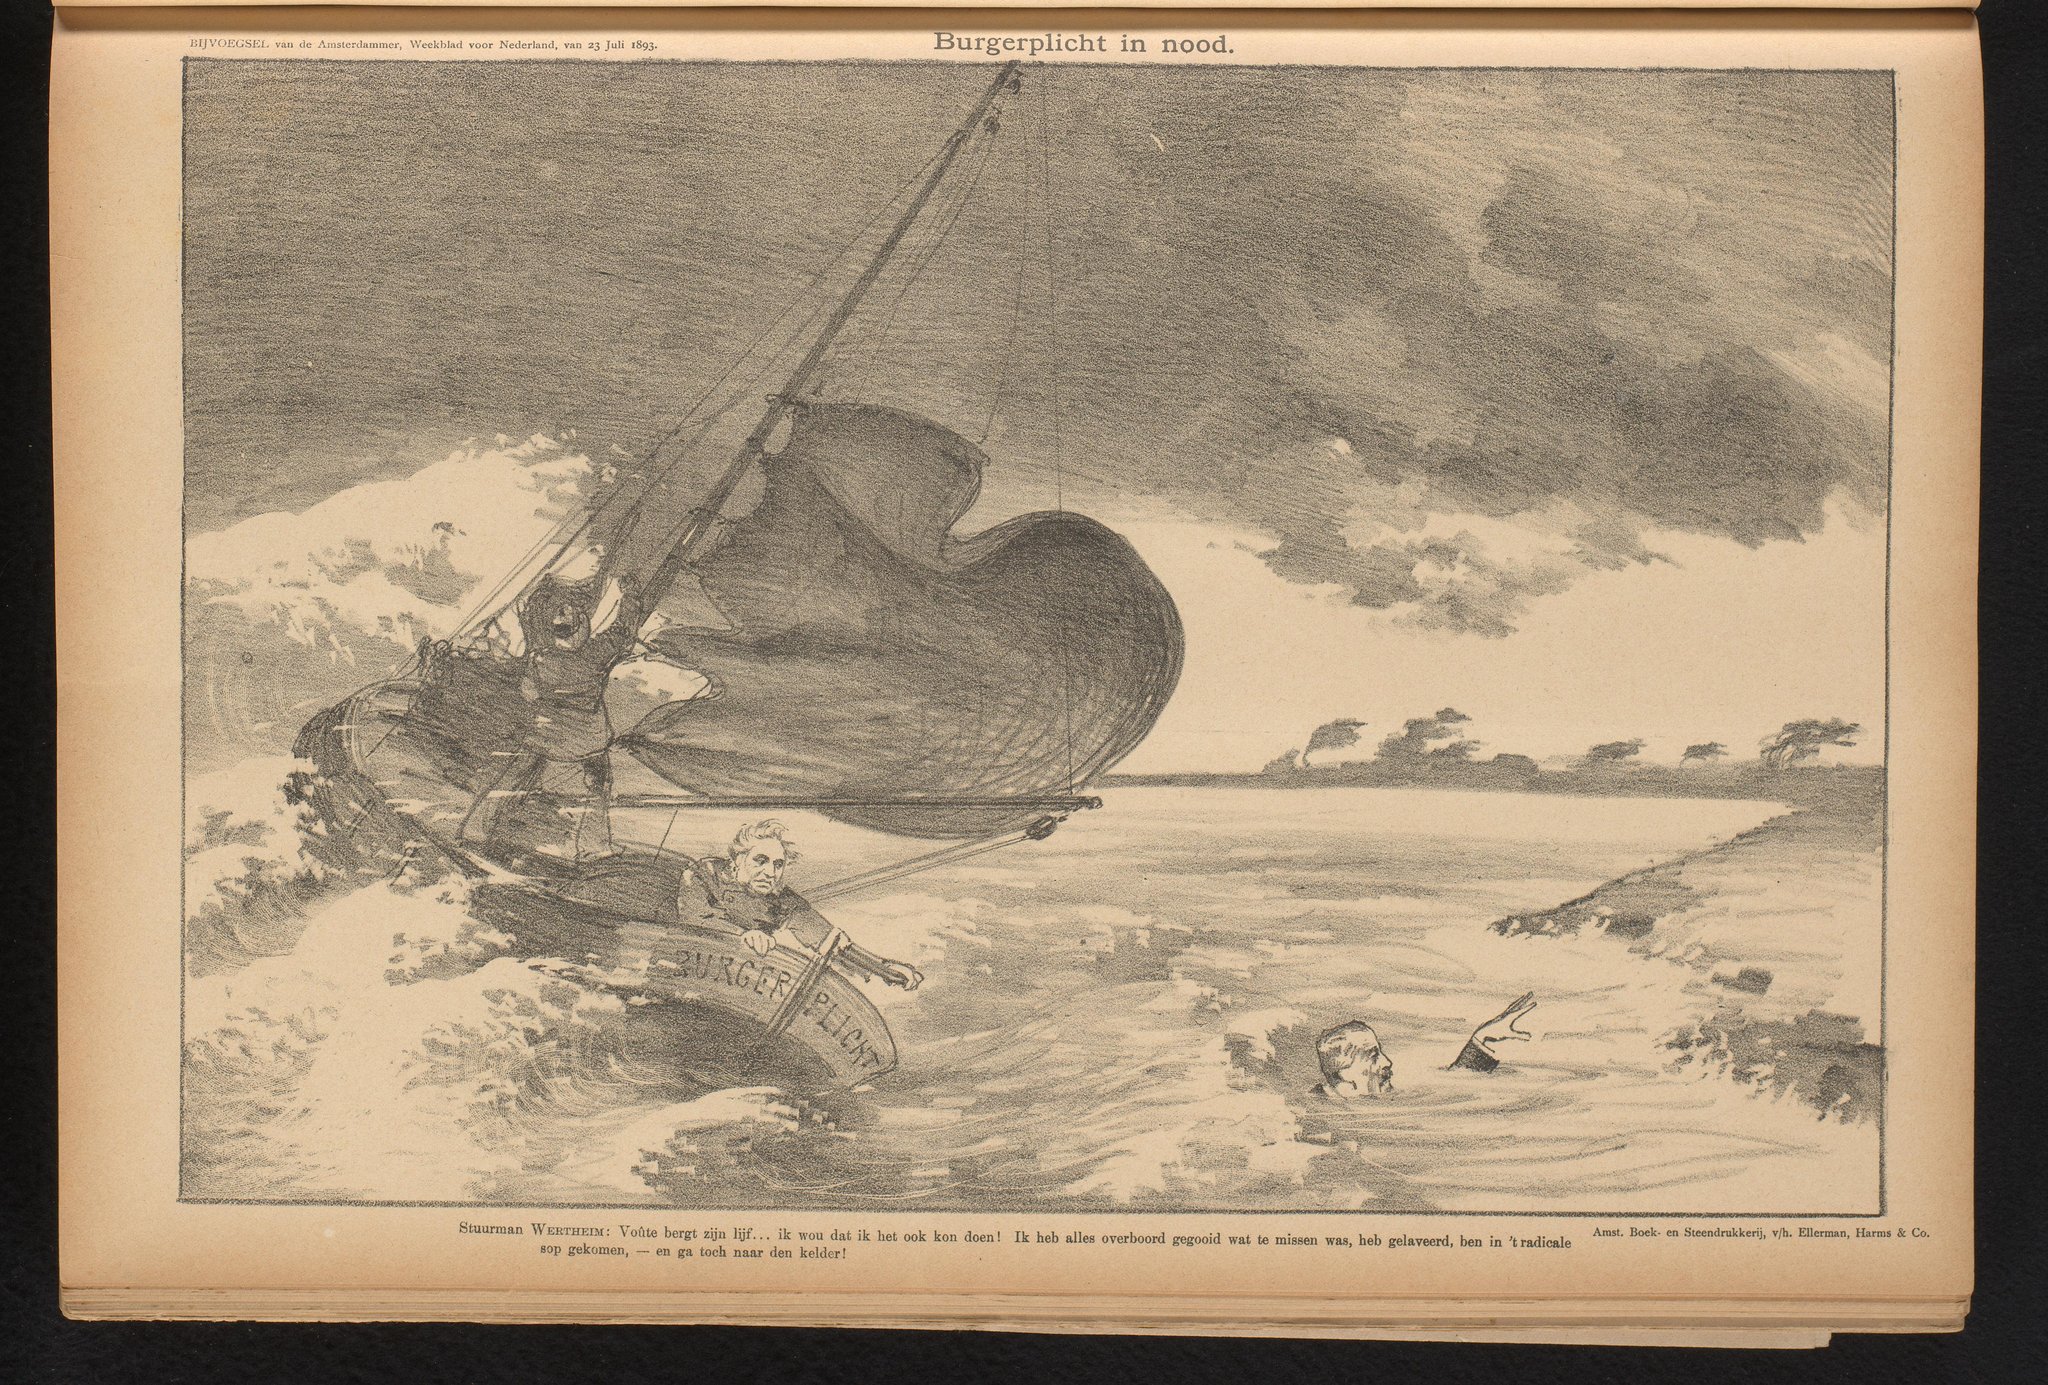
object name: cartoon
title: Burgerplicht in nood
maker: johan braakensiek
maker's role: draughtsman, print maker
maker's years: 1858-1940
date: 1893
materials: paper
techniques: lithograph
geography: netherlands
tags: amsterdam, politician, storm at sea, political caricatures and satires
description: Abraham Carel Wertheim probeert als stuurman zijn schip 'Burgerplicht' nog te redden tijdens een storm op zee. Zijn helper Voûte is al van boord gesprongen en zwemt naar de kust.